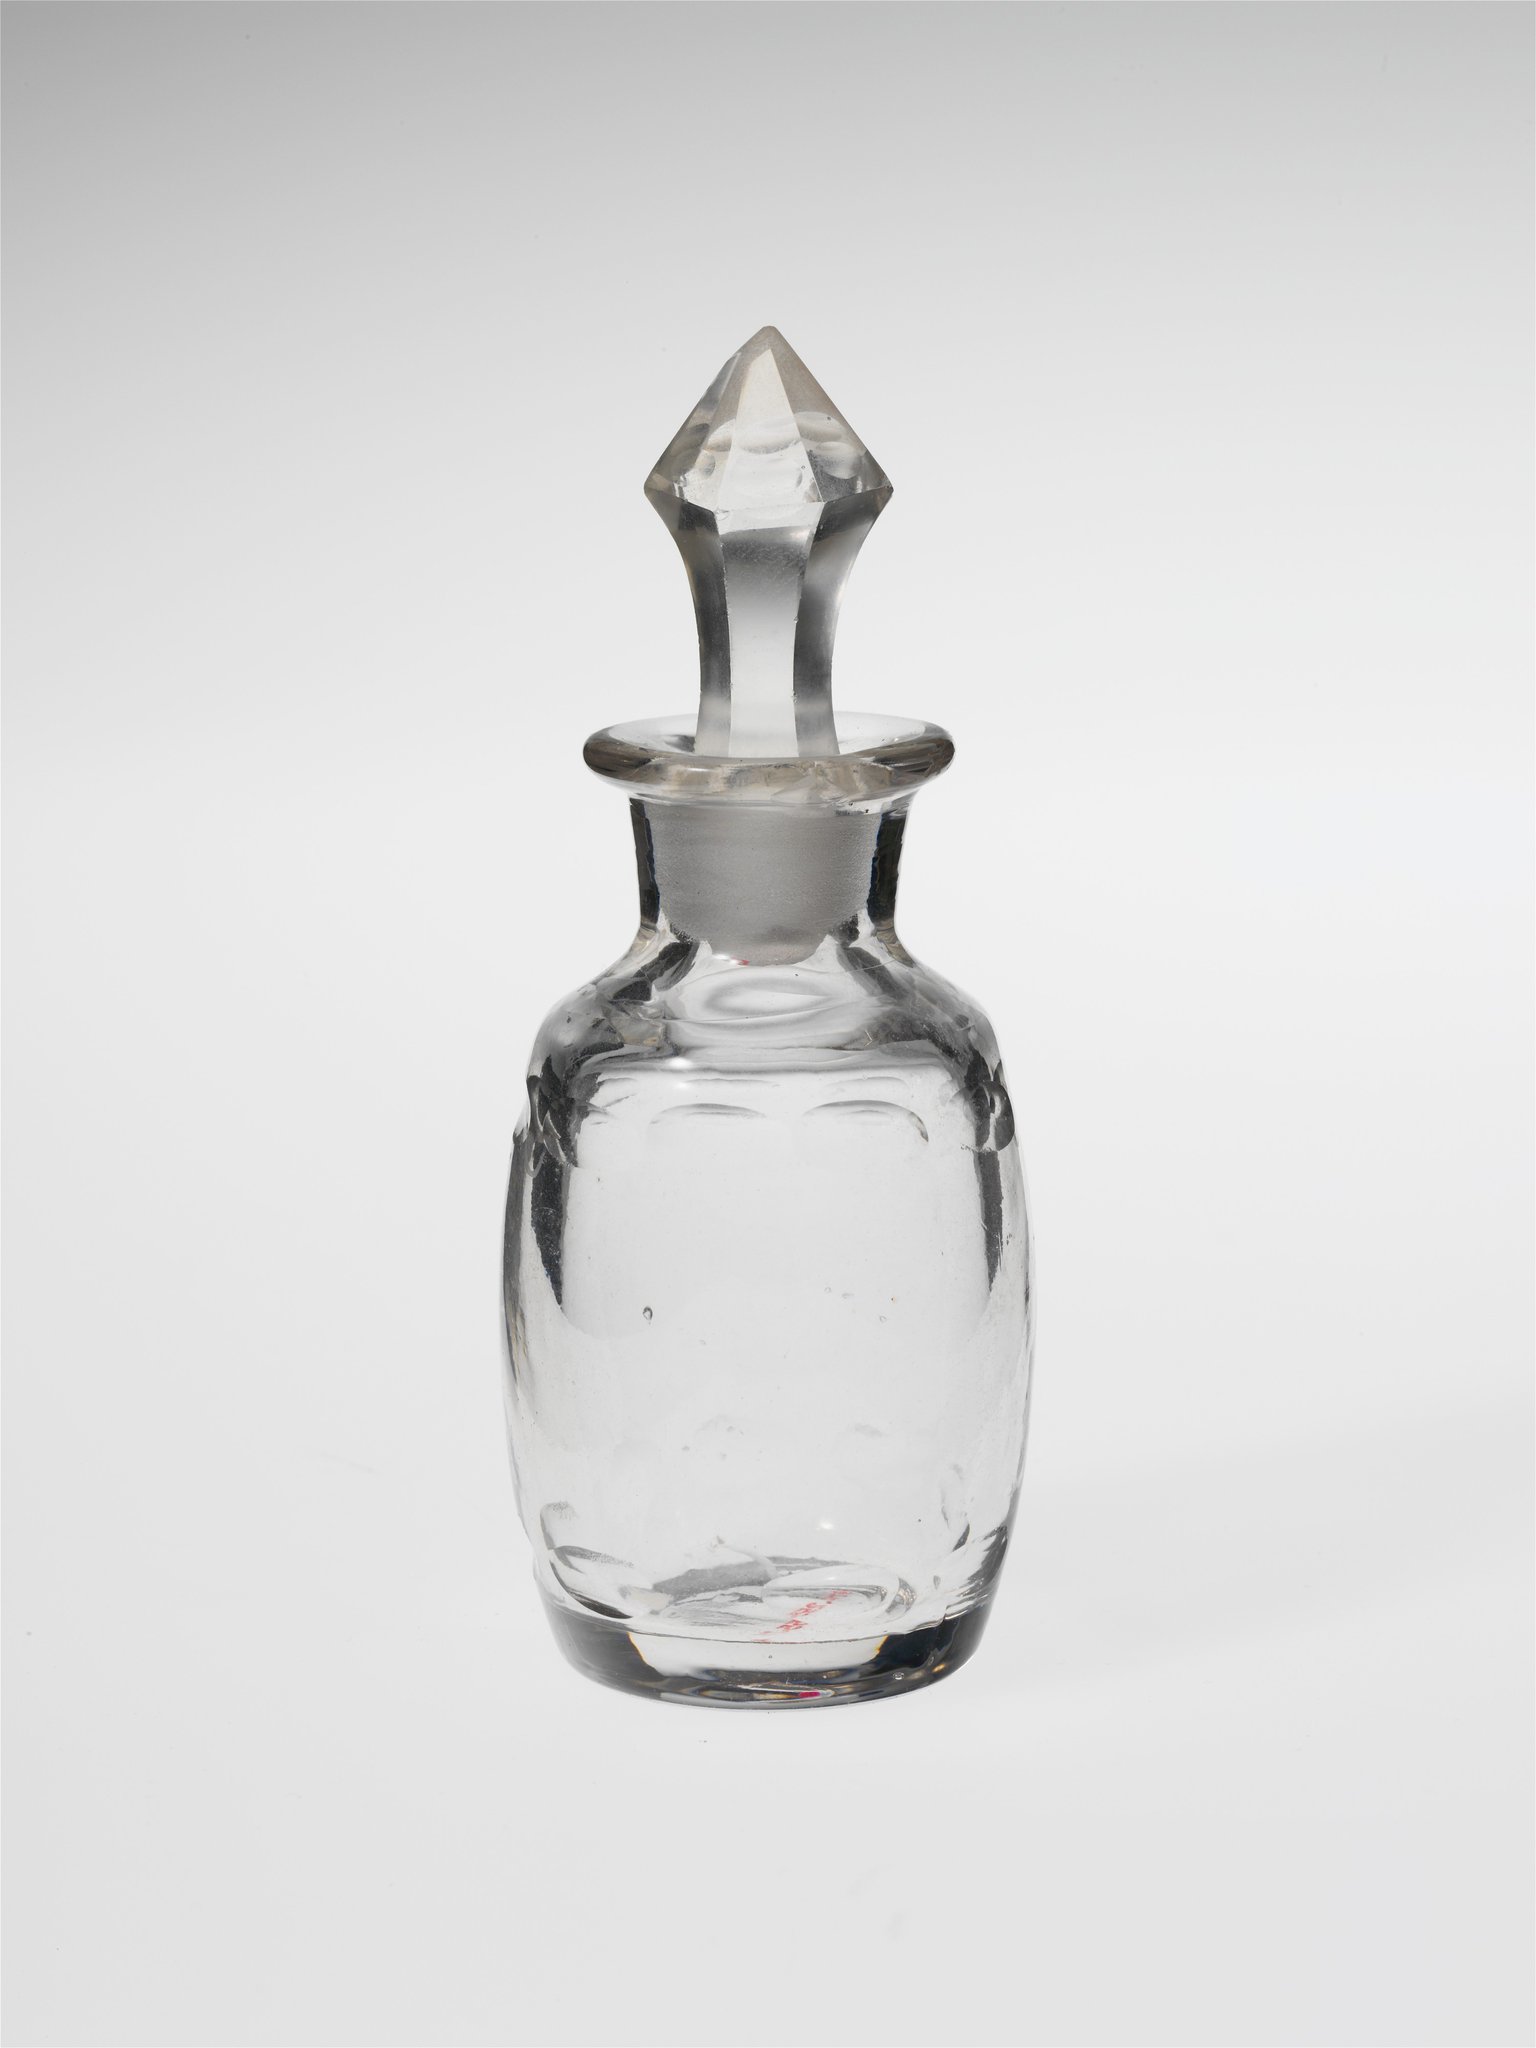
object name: bottle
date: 1700-1800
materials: glass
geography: ireland